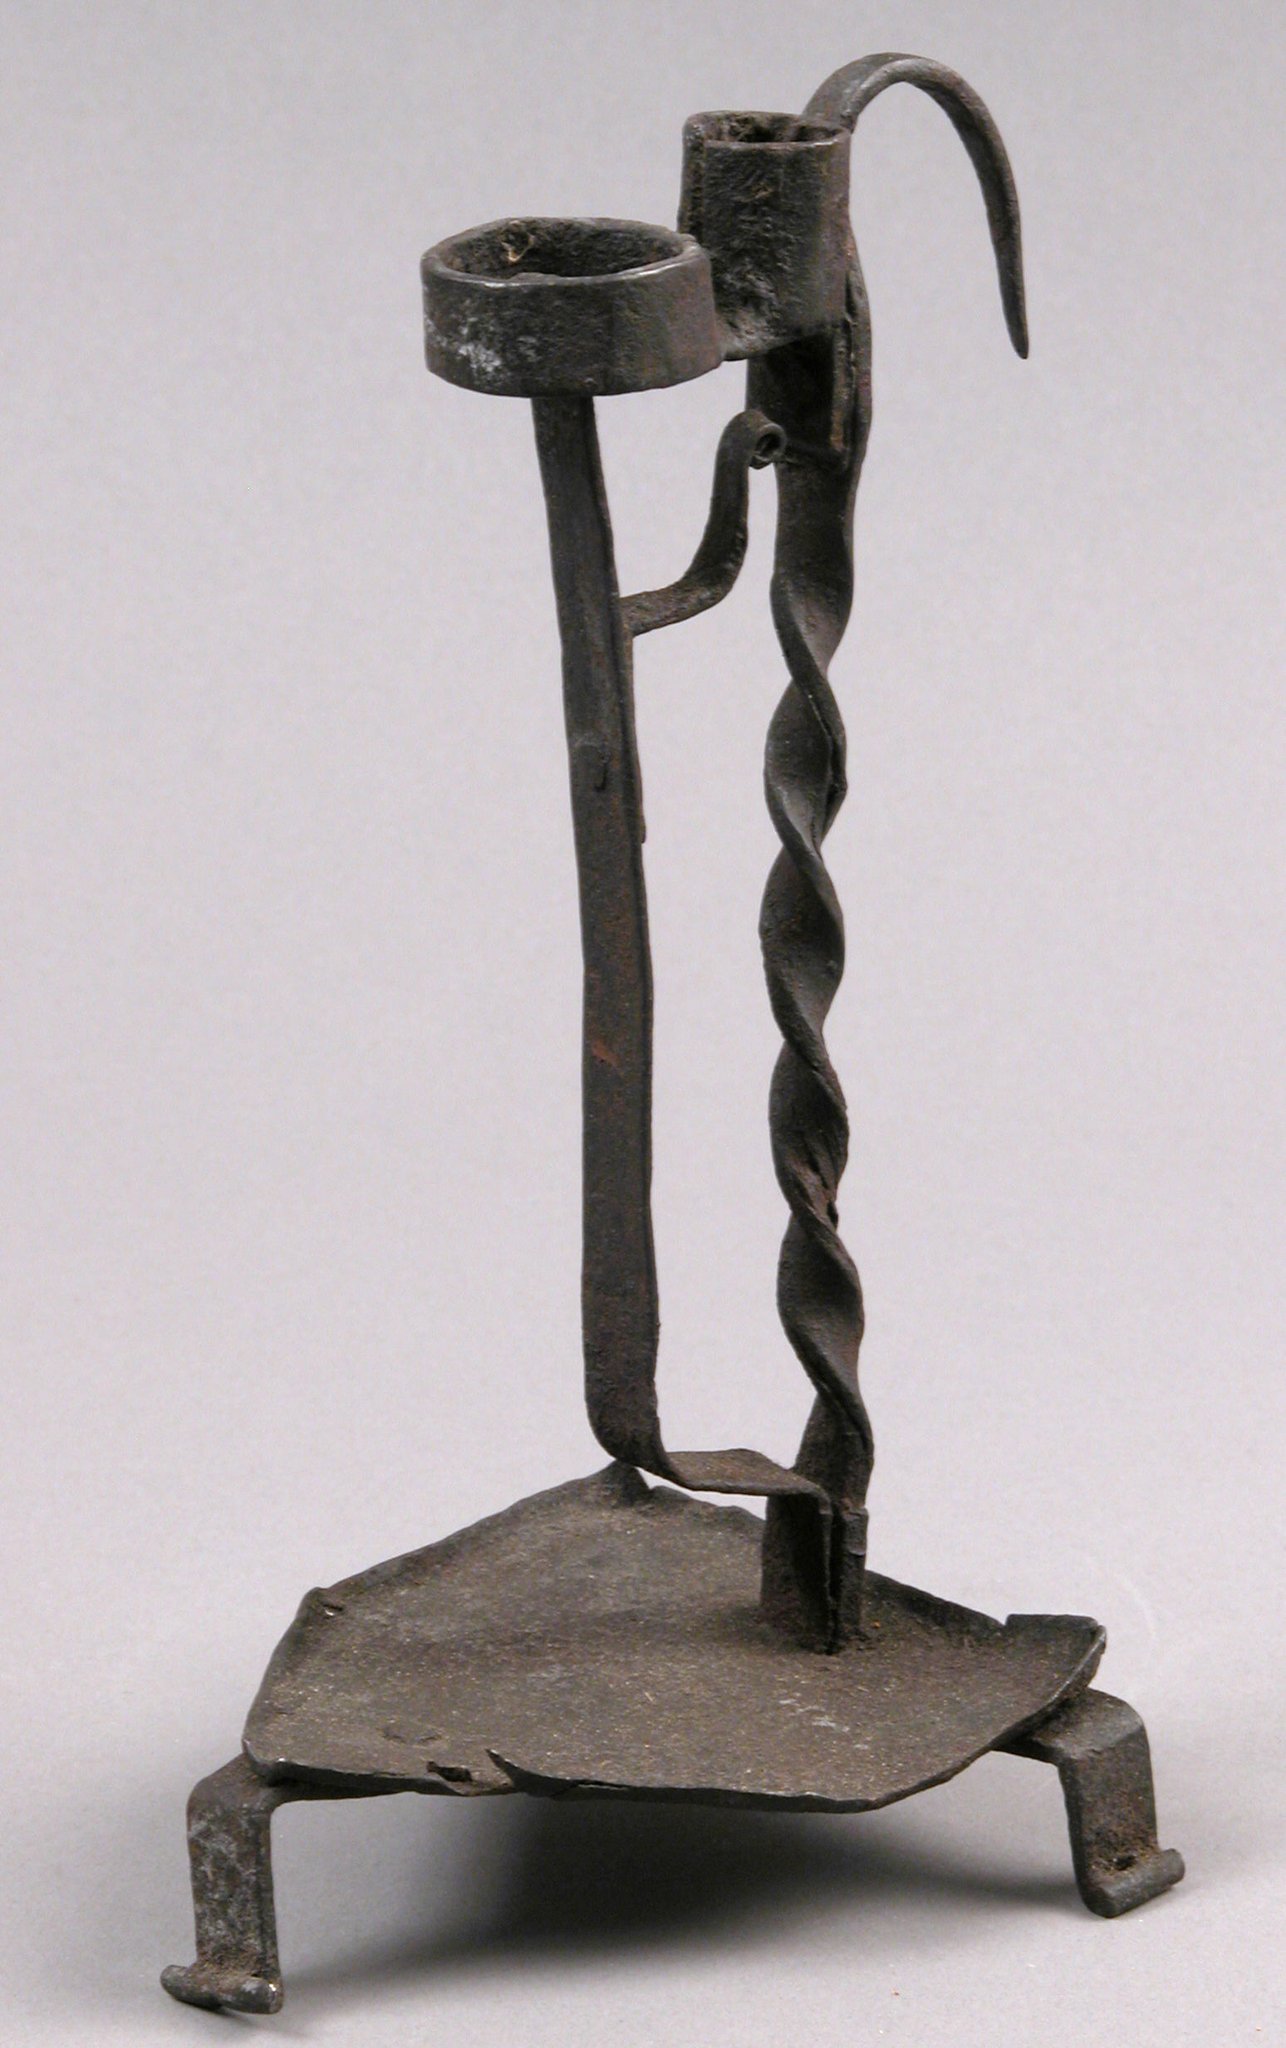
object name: candlestick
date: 1401-1600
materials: iron